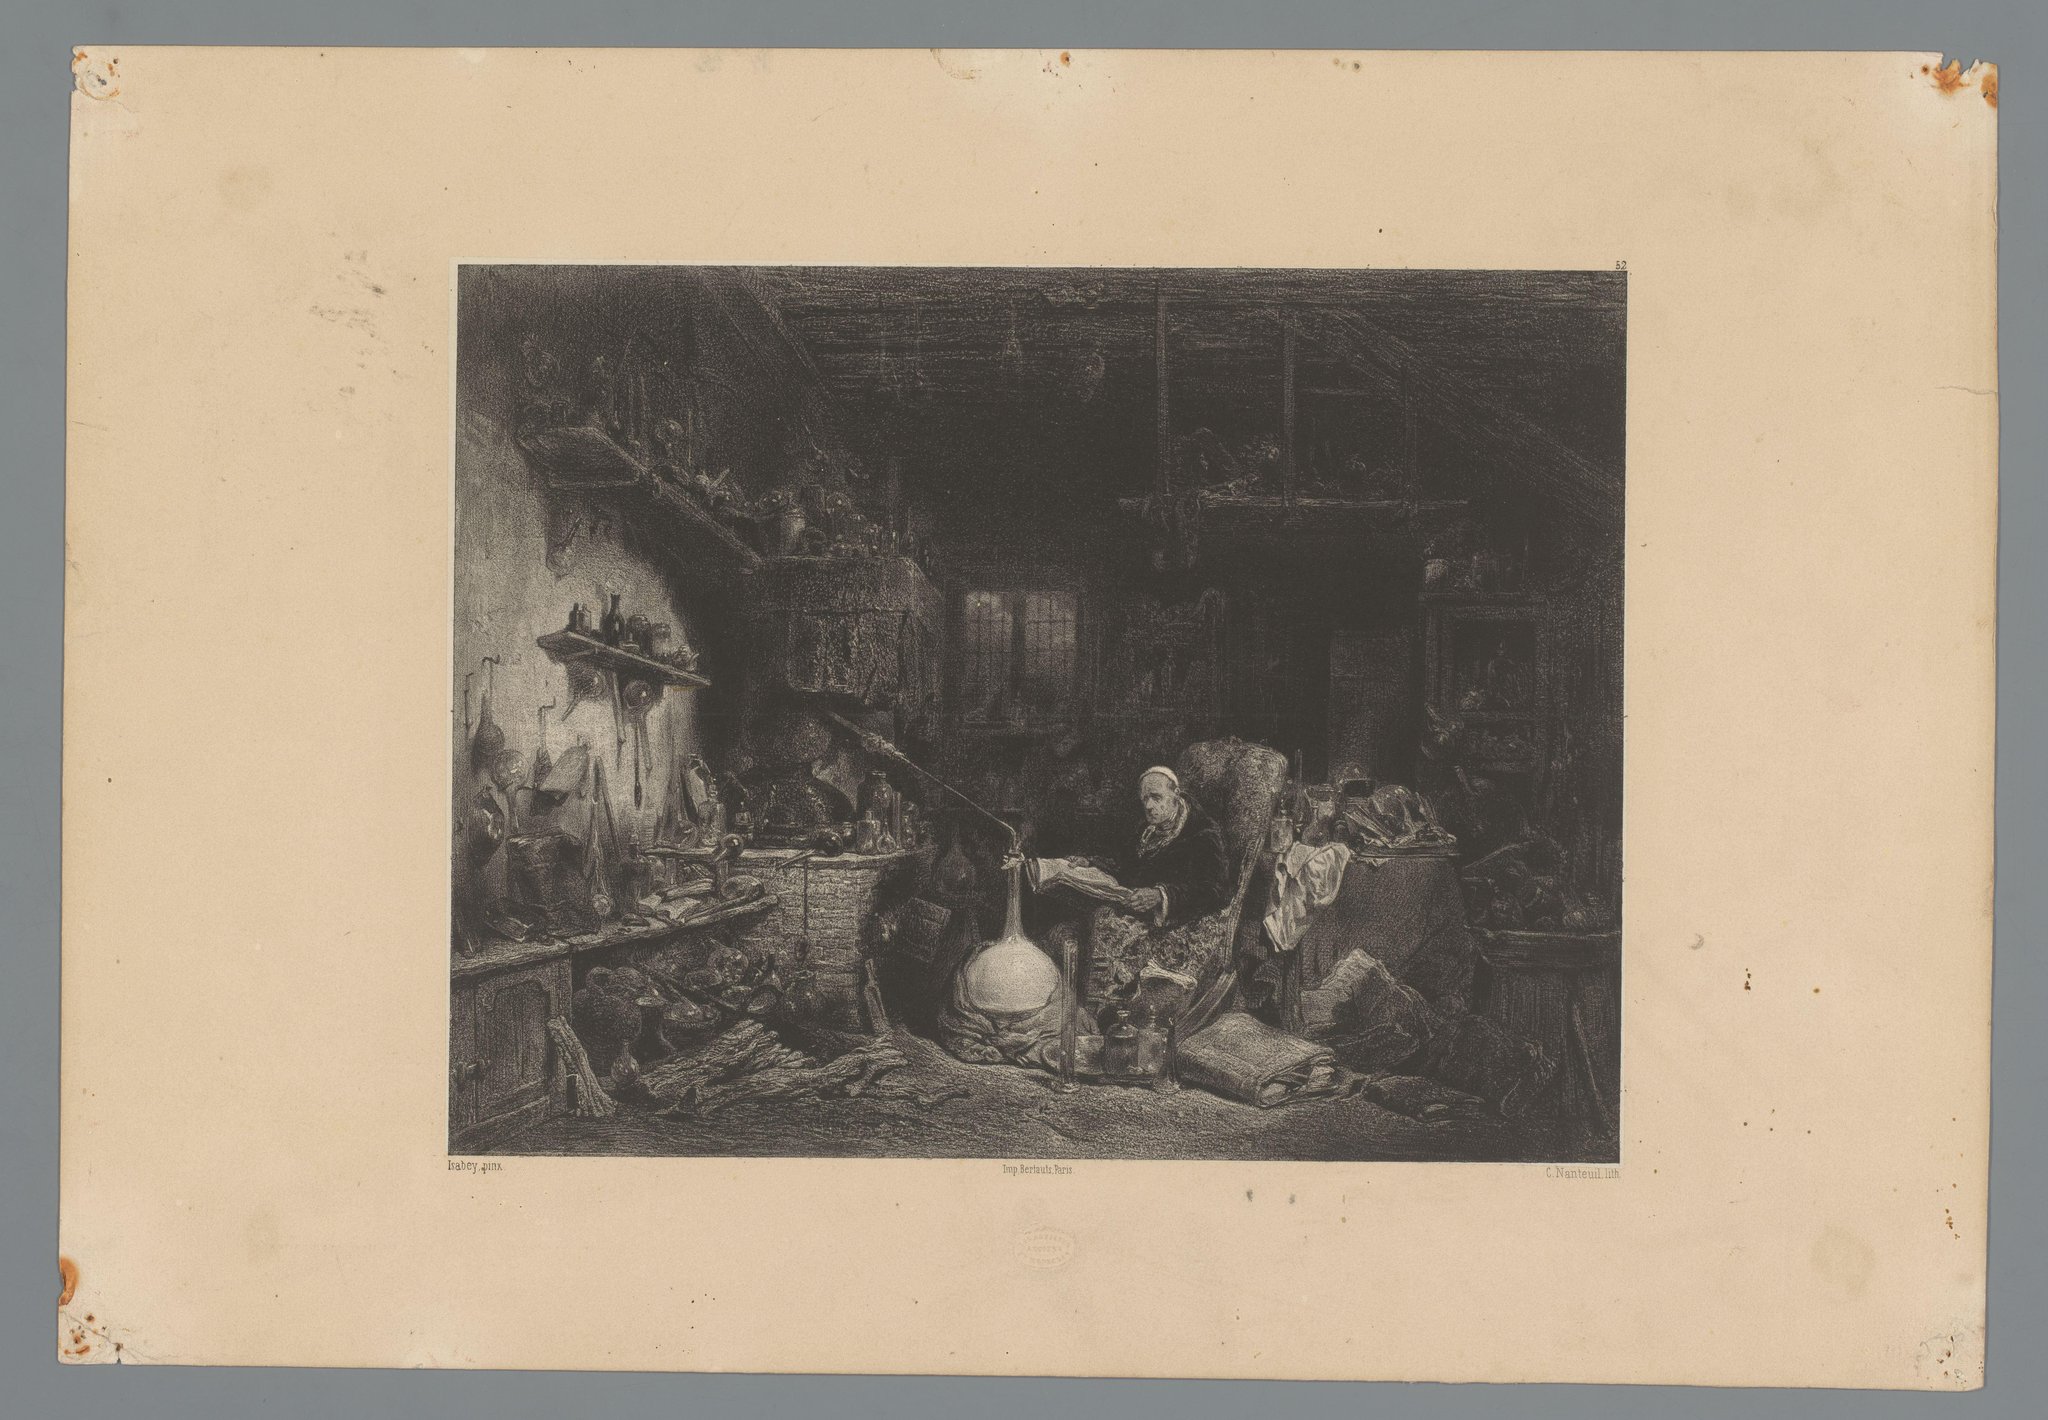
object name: print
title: Oude en hedendaagse kunstenaars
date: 1848-1862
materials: paper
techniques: lithograph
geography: paris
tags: alchemist at work, workshop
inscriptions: check stamp: Lugt 36a, collector's mark: Lugt 2233, inscription: ‘Aug Allebé’